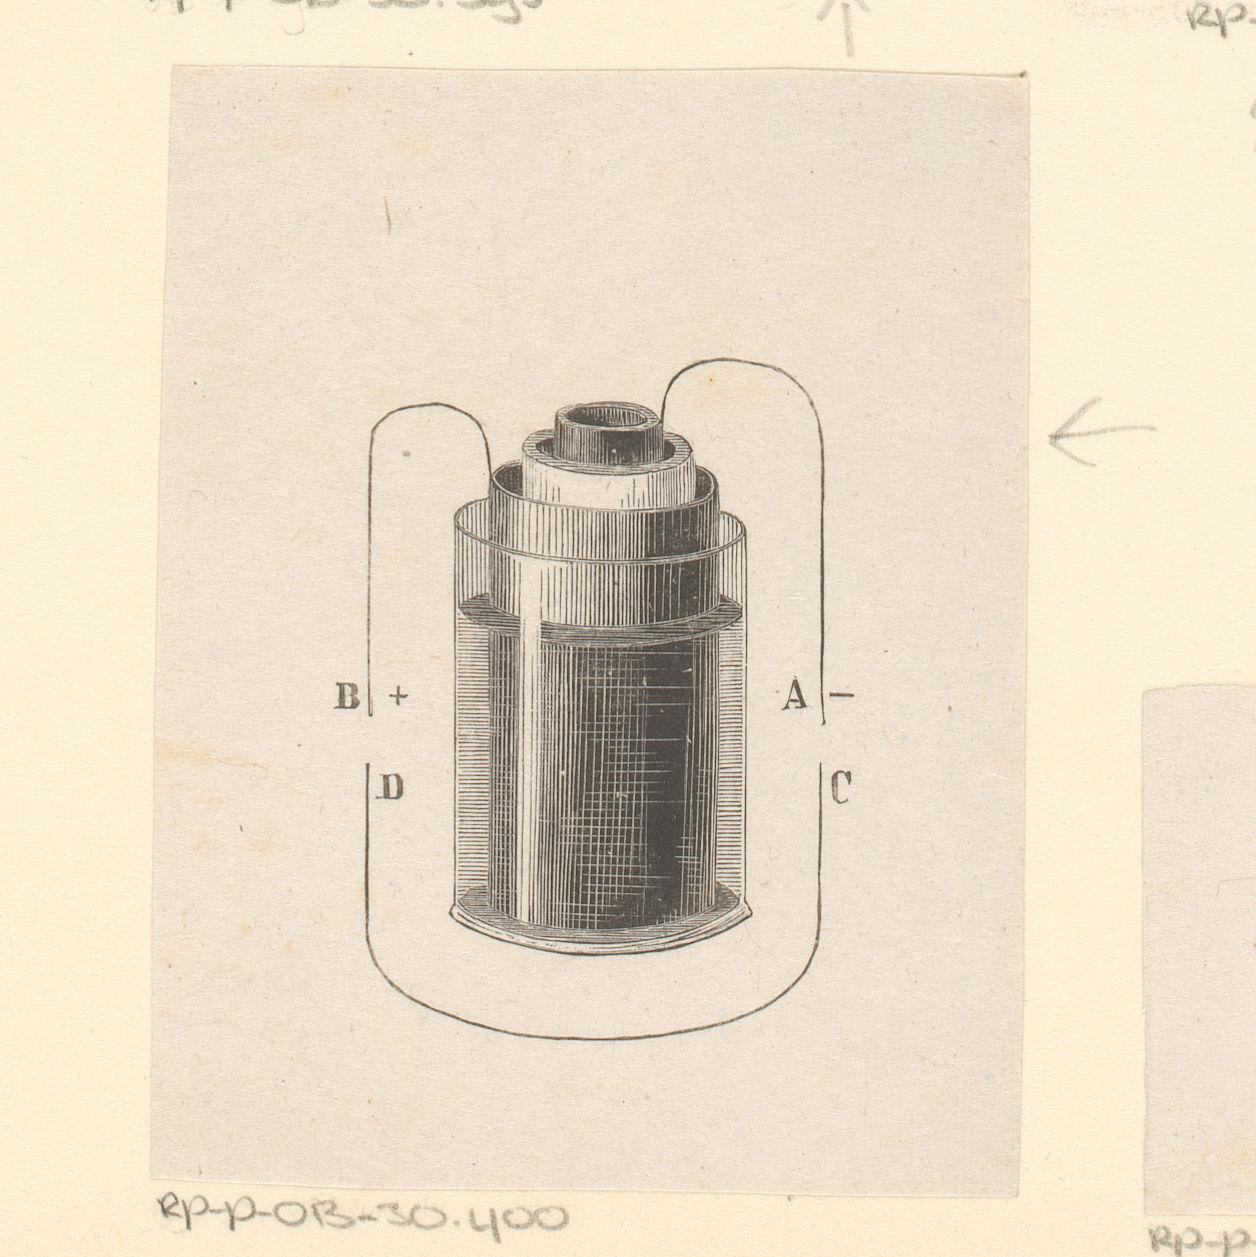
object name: print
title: Doorsnede van een batterij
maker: isaac weissenbruch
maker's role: print maker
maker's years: 1826-1912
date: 1836-1912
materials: paper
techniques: engraving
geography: netherlands